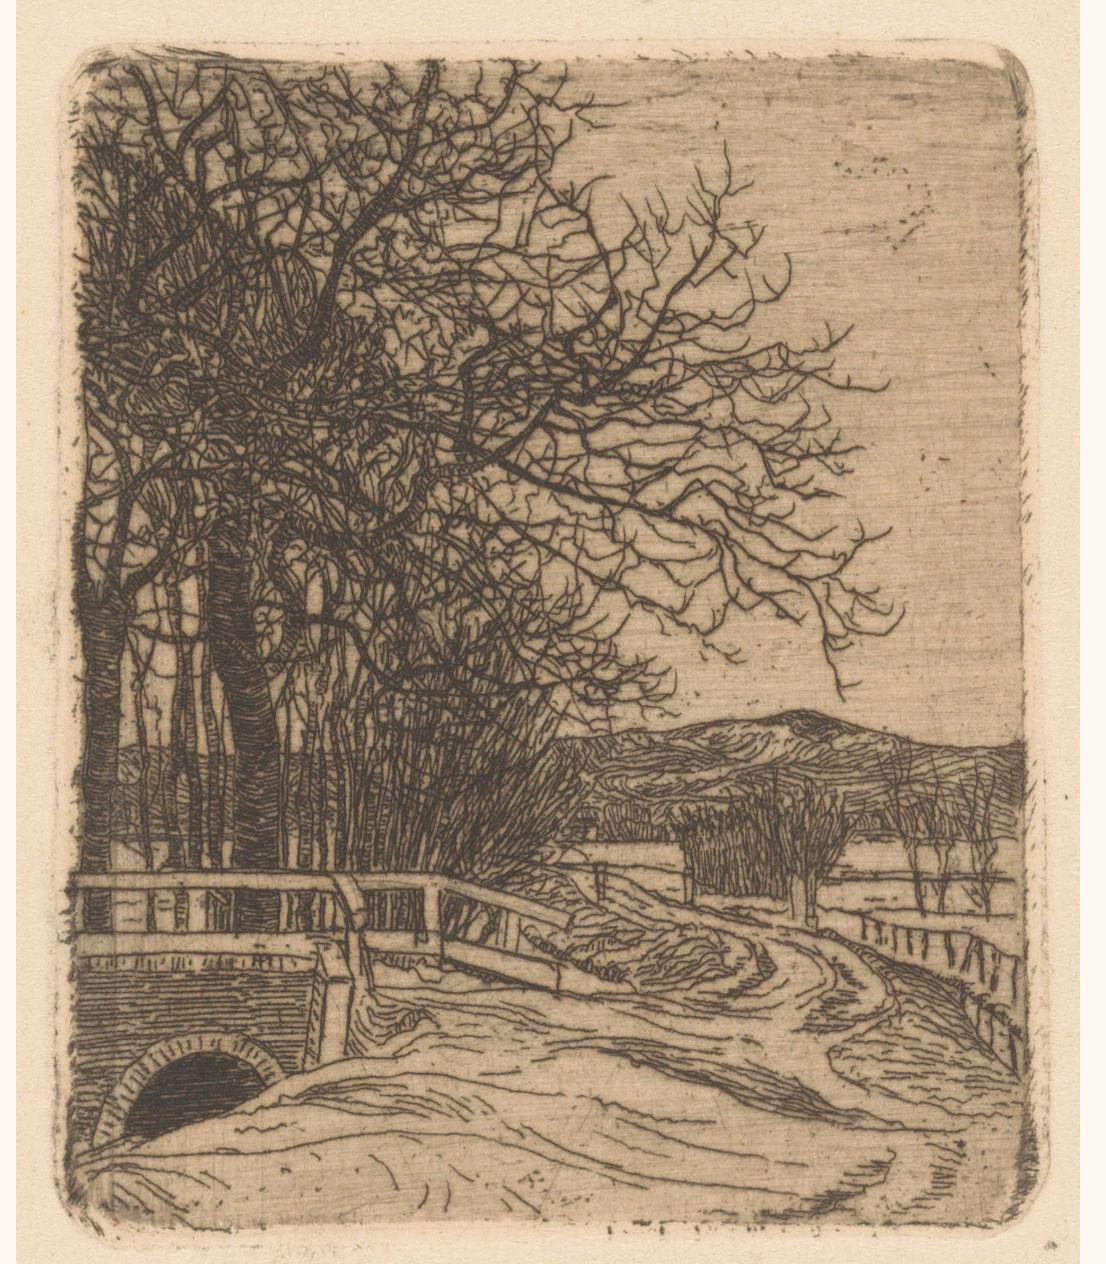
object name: print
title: Bij Noordwijk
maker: johannes henrichs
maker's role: print maker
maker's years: 1882-1954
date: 1909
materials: paper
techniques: etching, intaglio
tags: bridge, street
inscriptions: collector's mark: Lugt 2228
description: Een brug naast een weg bij Noordwijk. Op de achtergrond een duin.